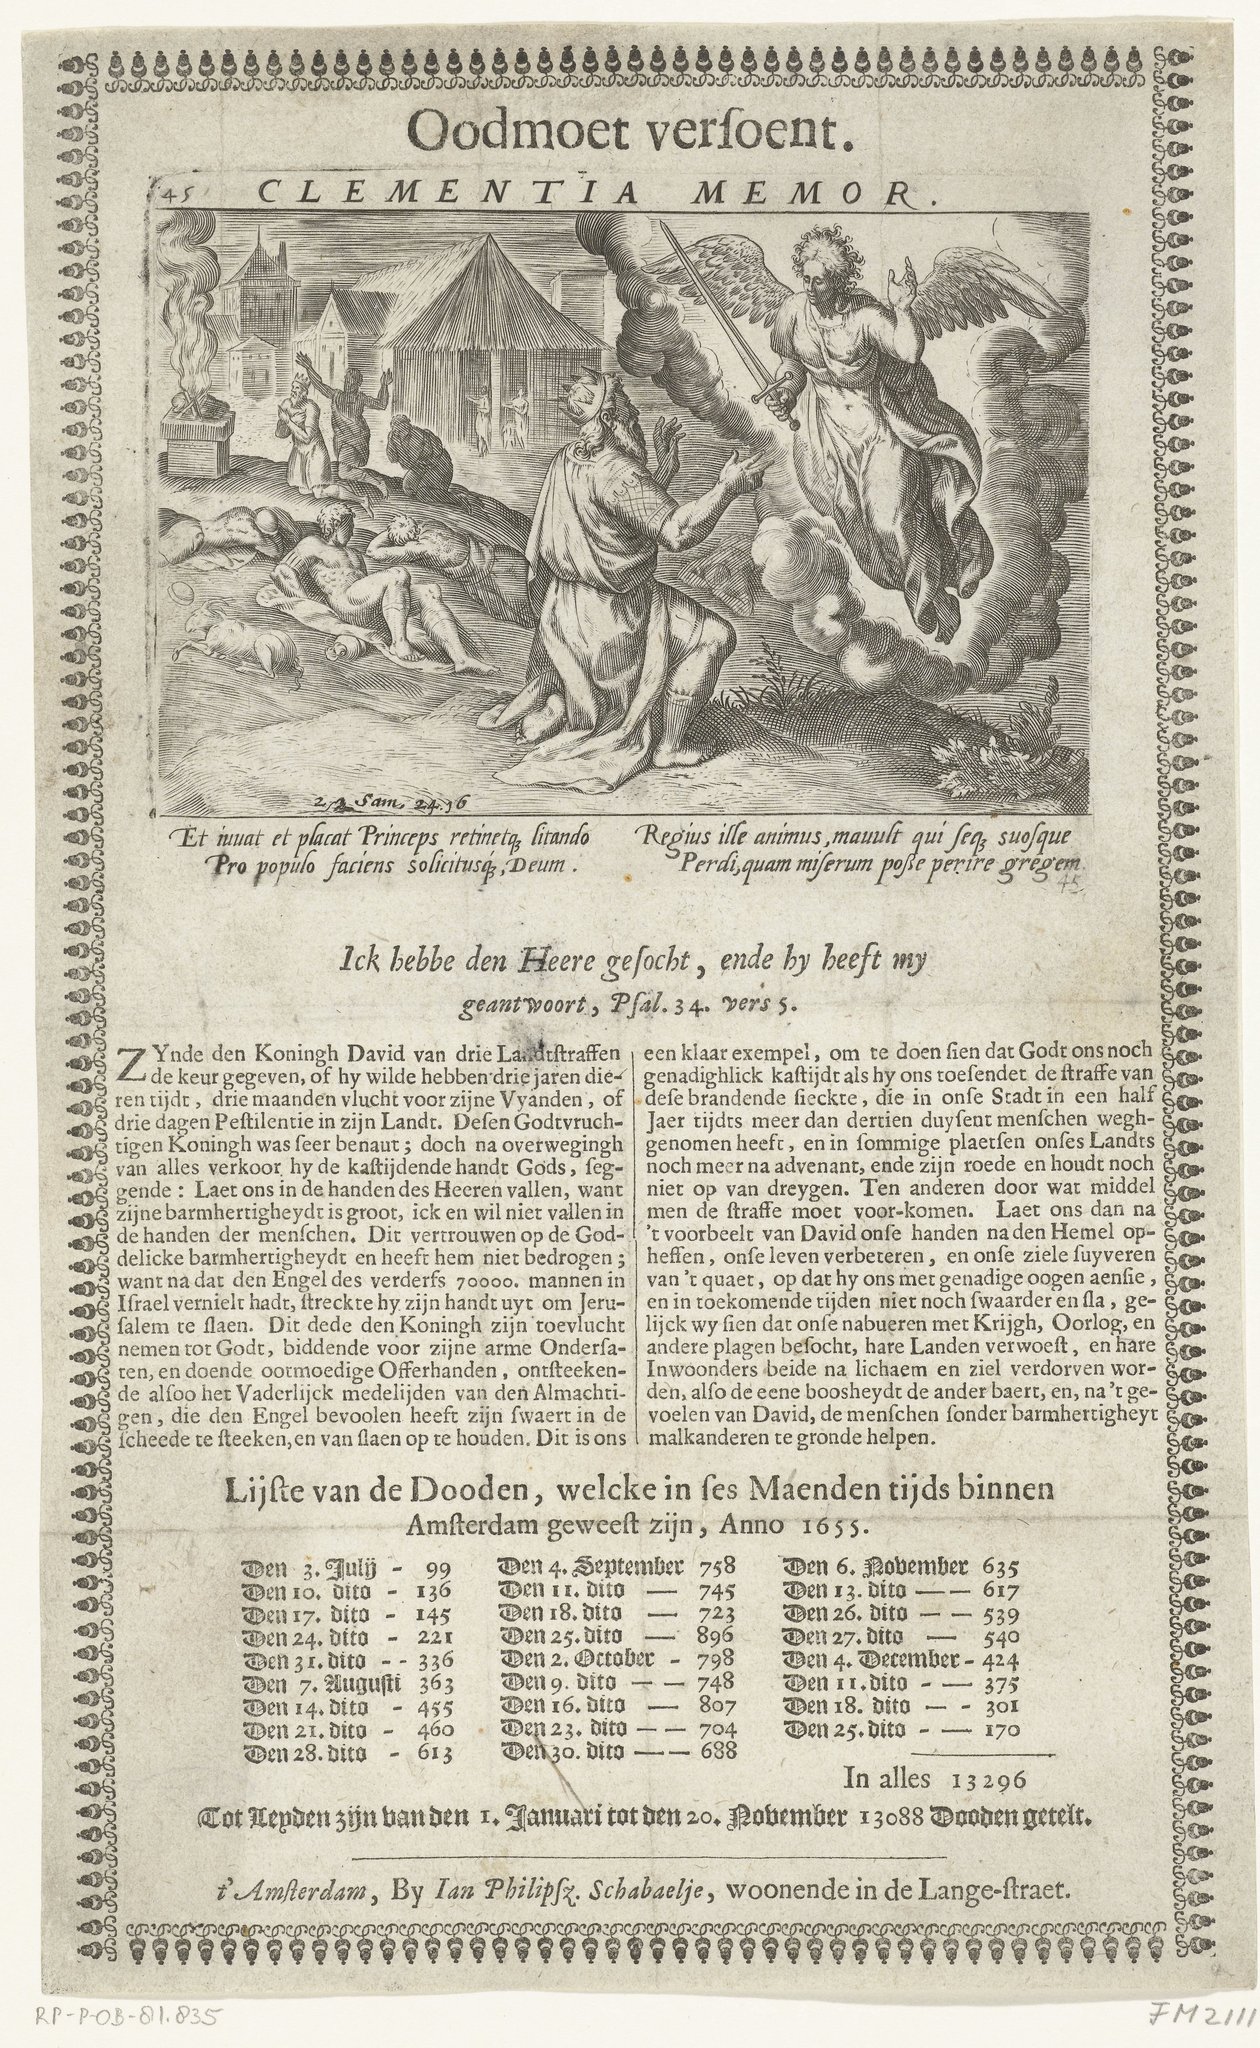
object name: print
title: Oodmoet versoent / Clementia Memor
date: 1655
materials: paper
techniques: engraving, letterpress printing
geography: northern netherlands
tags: david sees the avenging angel in jerusalem; he prays to god, leiden, amsterdam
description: Blad met oude plaat van de verschijning van wrekende engel Gods aan koning David, op de achtergrond de slachtoffers van de door God opgelegde straf van drie dagen pest. De oude plaat genummerd: 45. Op het blad onder de plaat is een tekst gedrukt waarin de pest die in de maanden juli-december 1654 in de stad Amsterdam woedt, geïnterpreteerd wordt als een straf van God. Met een lijst van de doden per maand in Amsterdam en in Leiden. Met enkele bijbelcitaten.